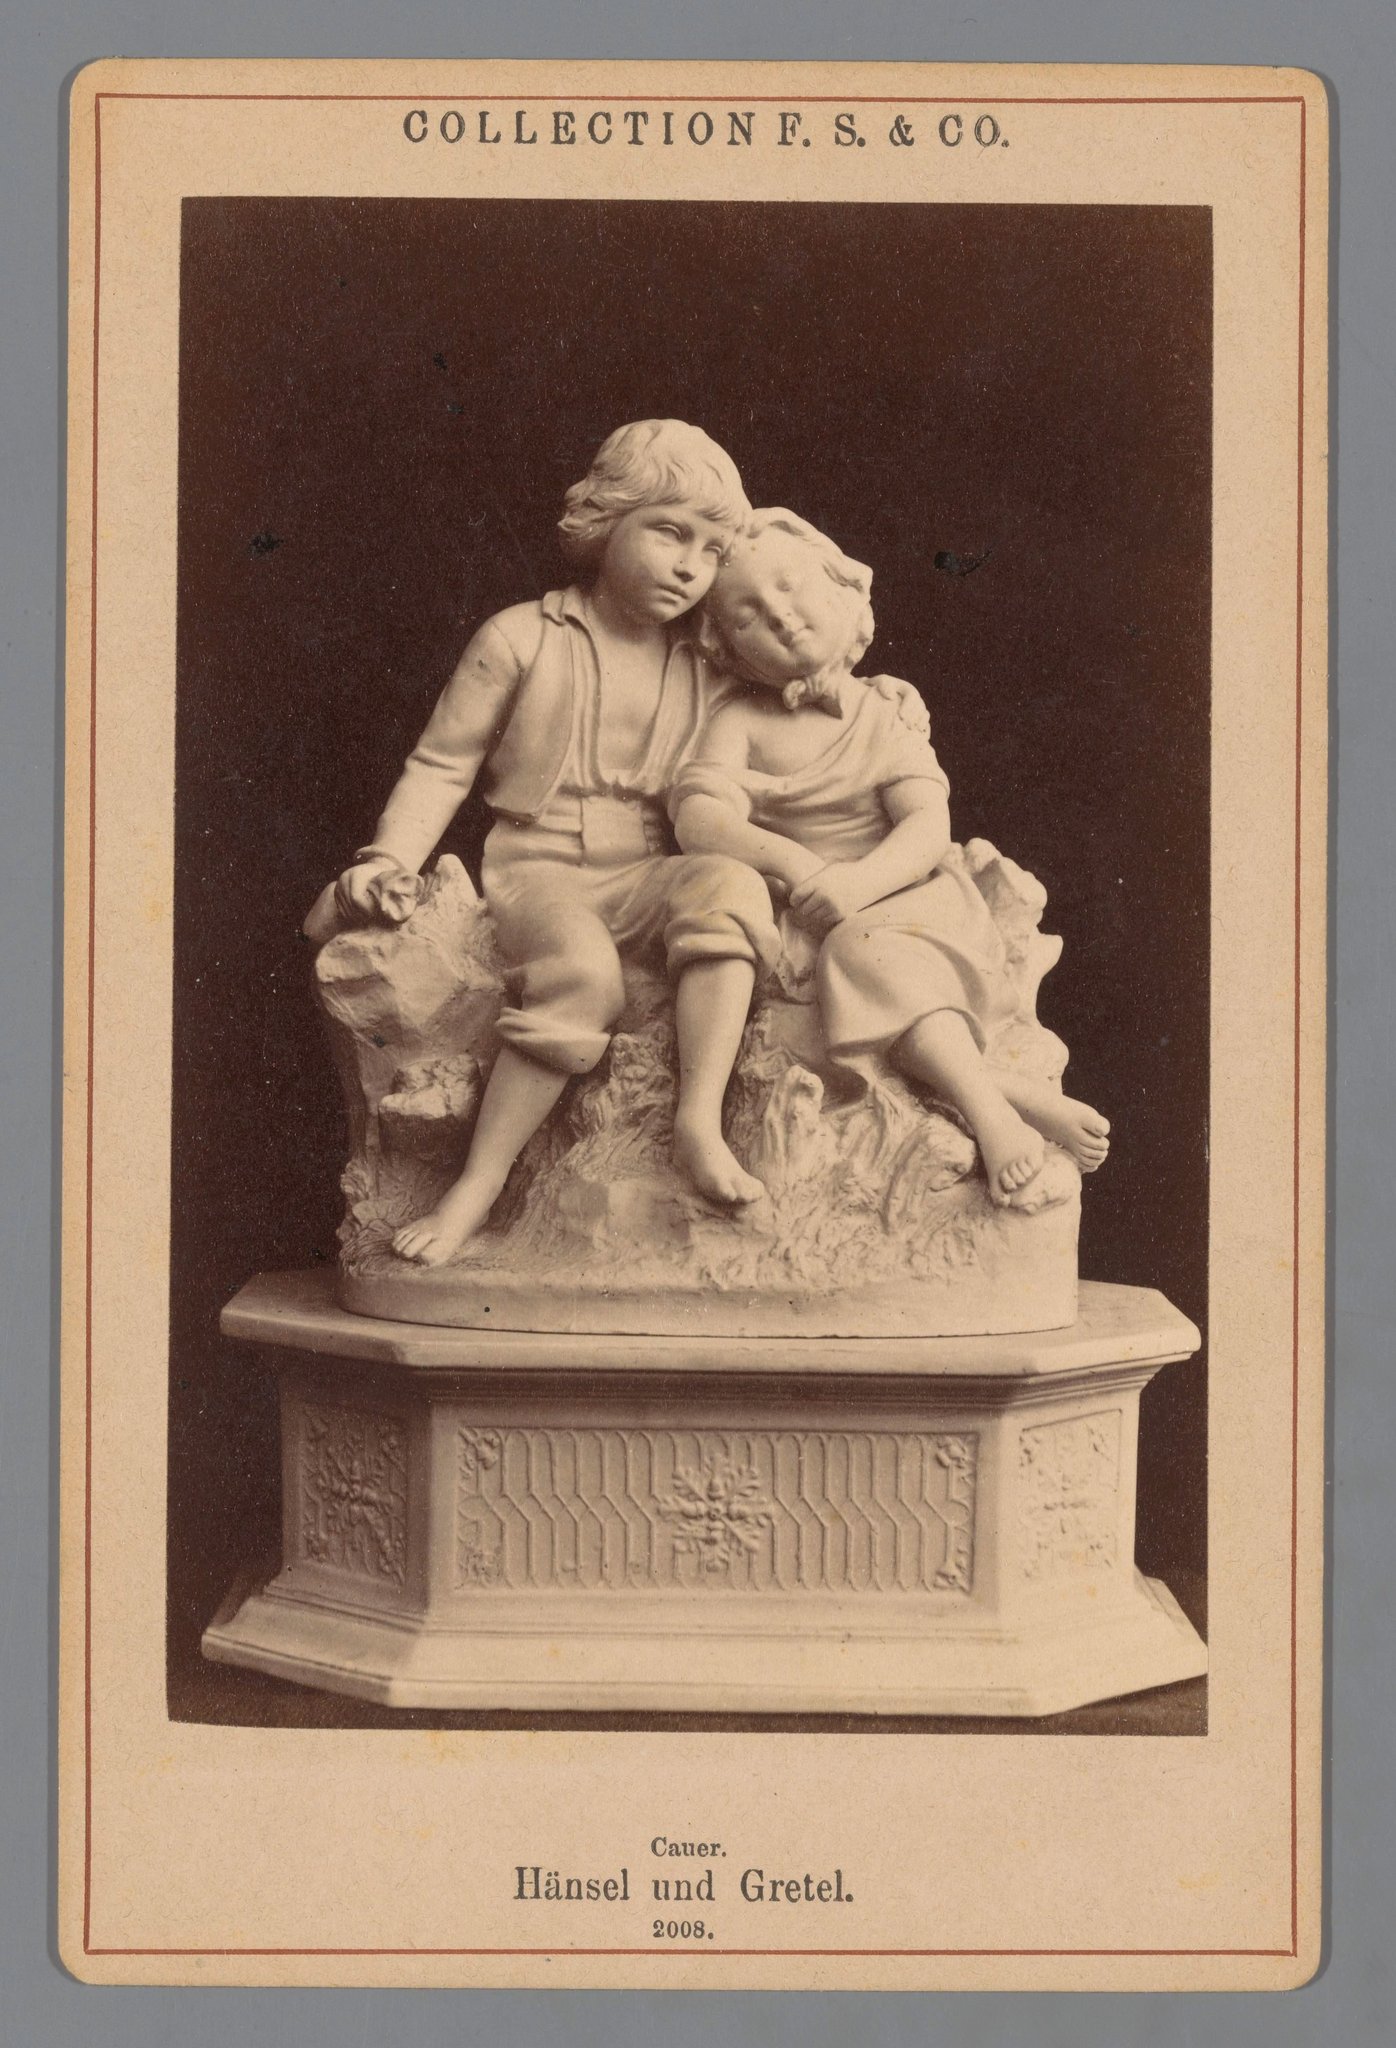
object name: cabinet photograph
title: Sculptuur van Hans en Grietje door vermoedelijk Carl Cauer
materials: cardboard, photographic support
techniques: albumen print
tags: piece of sculpture, reproduction of a piece of sculpture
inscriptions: number: ‘2008.’